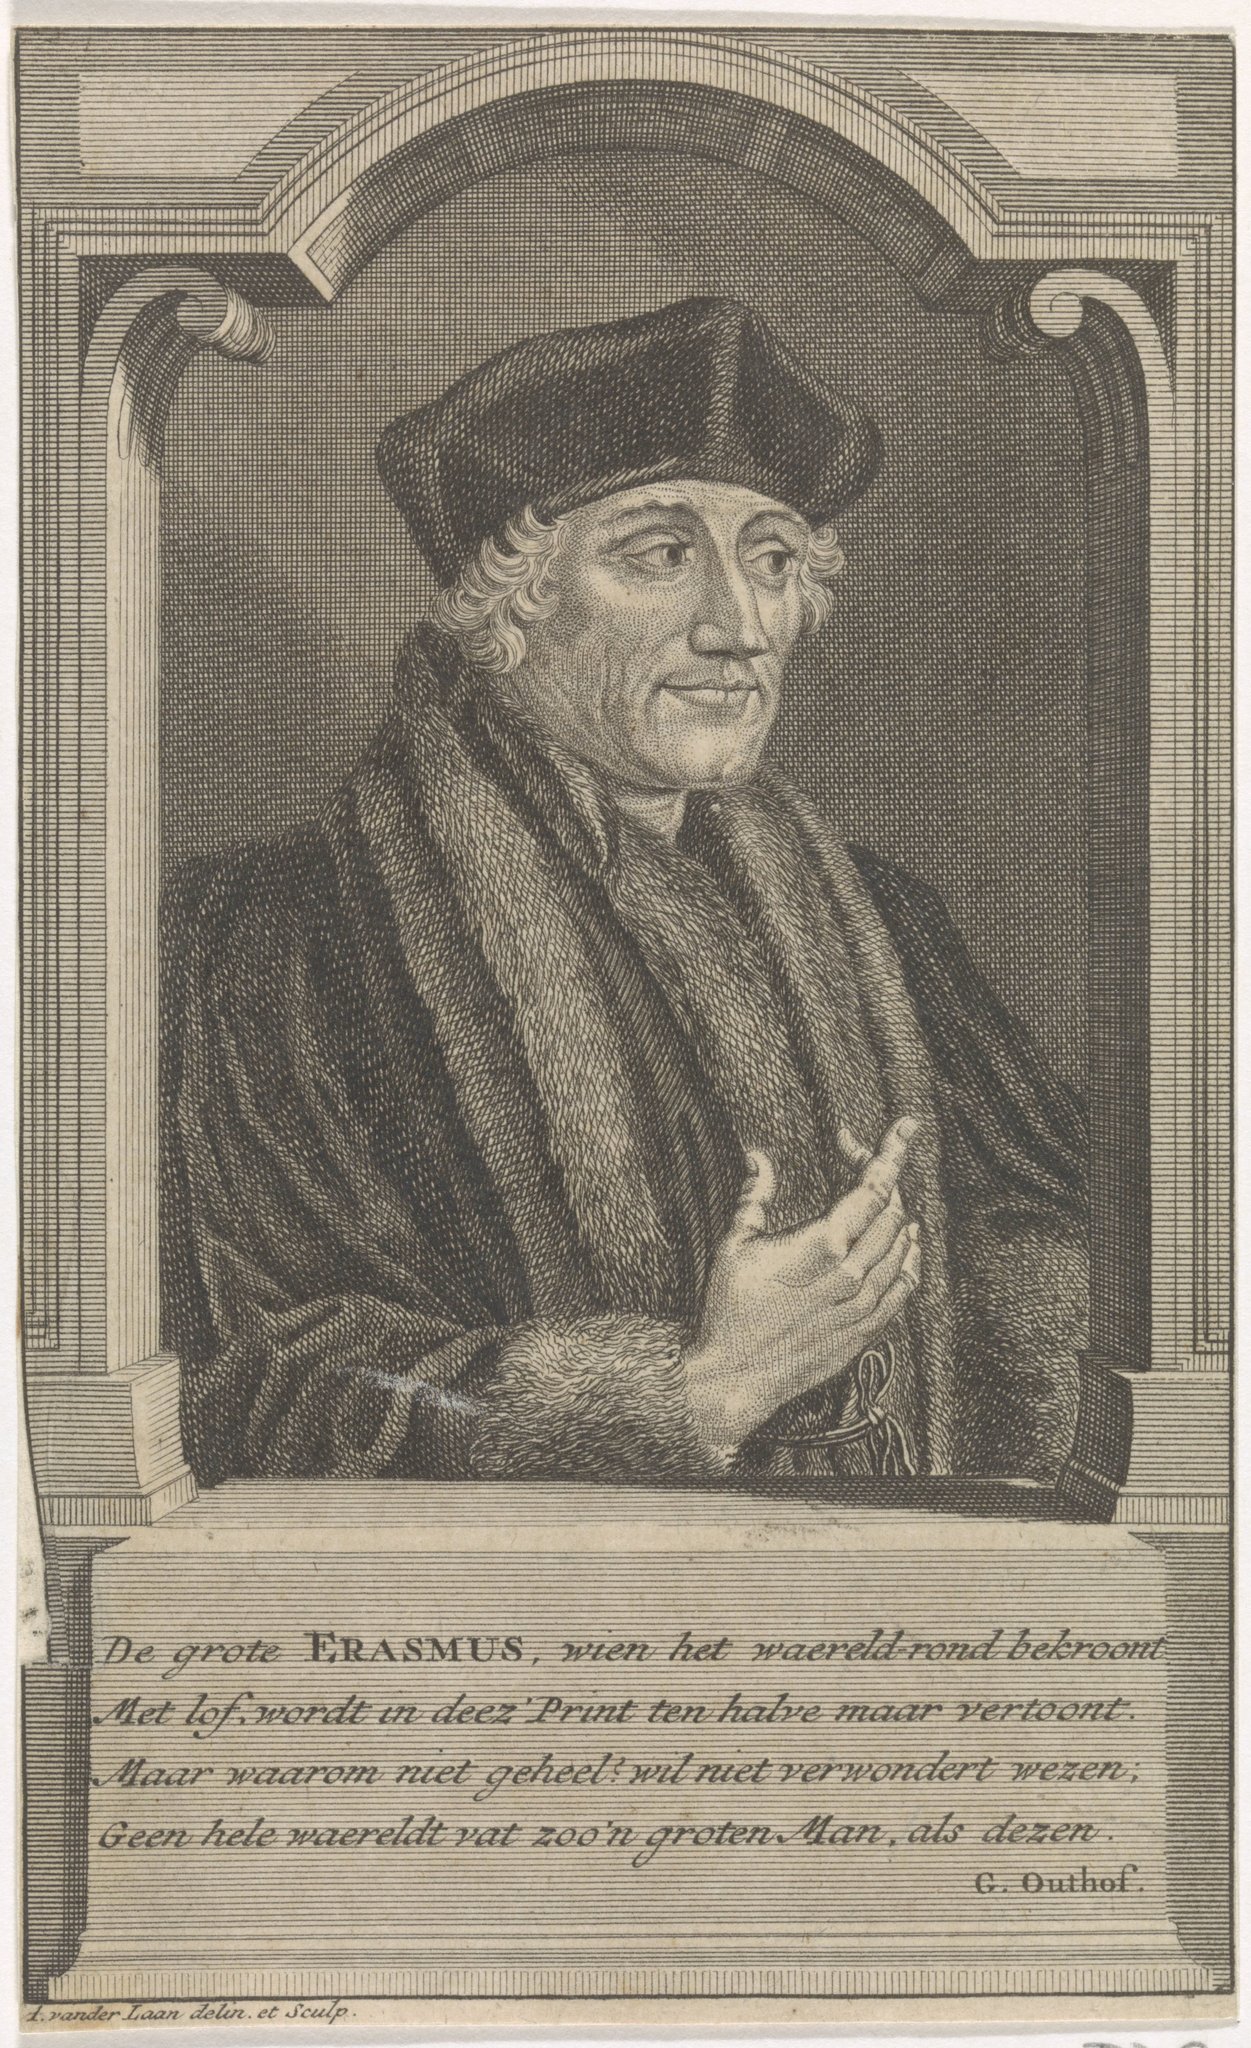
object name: print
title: Portret van Desiderius Erasmus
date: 1694-1755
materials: paper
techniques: engraving, etching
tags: desiderius erasmus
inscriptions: collector's mark: Lugt 2228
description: Portretbuste naar rechts van de Rotterdamse humanist Desiderius Erasmus, met baret en gehuld in een met bont afgezette mantel. Rondom een toogvormige omlijsting, onder het portret een achtregelig Nederlands vers.